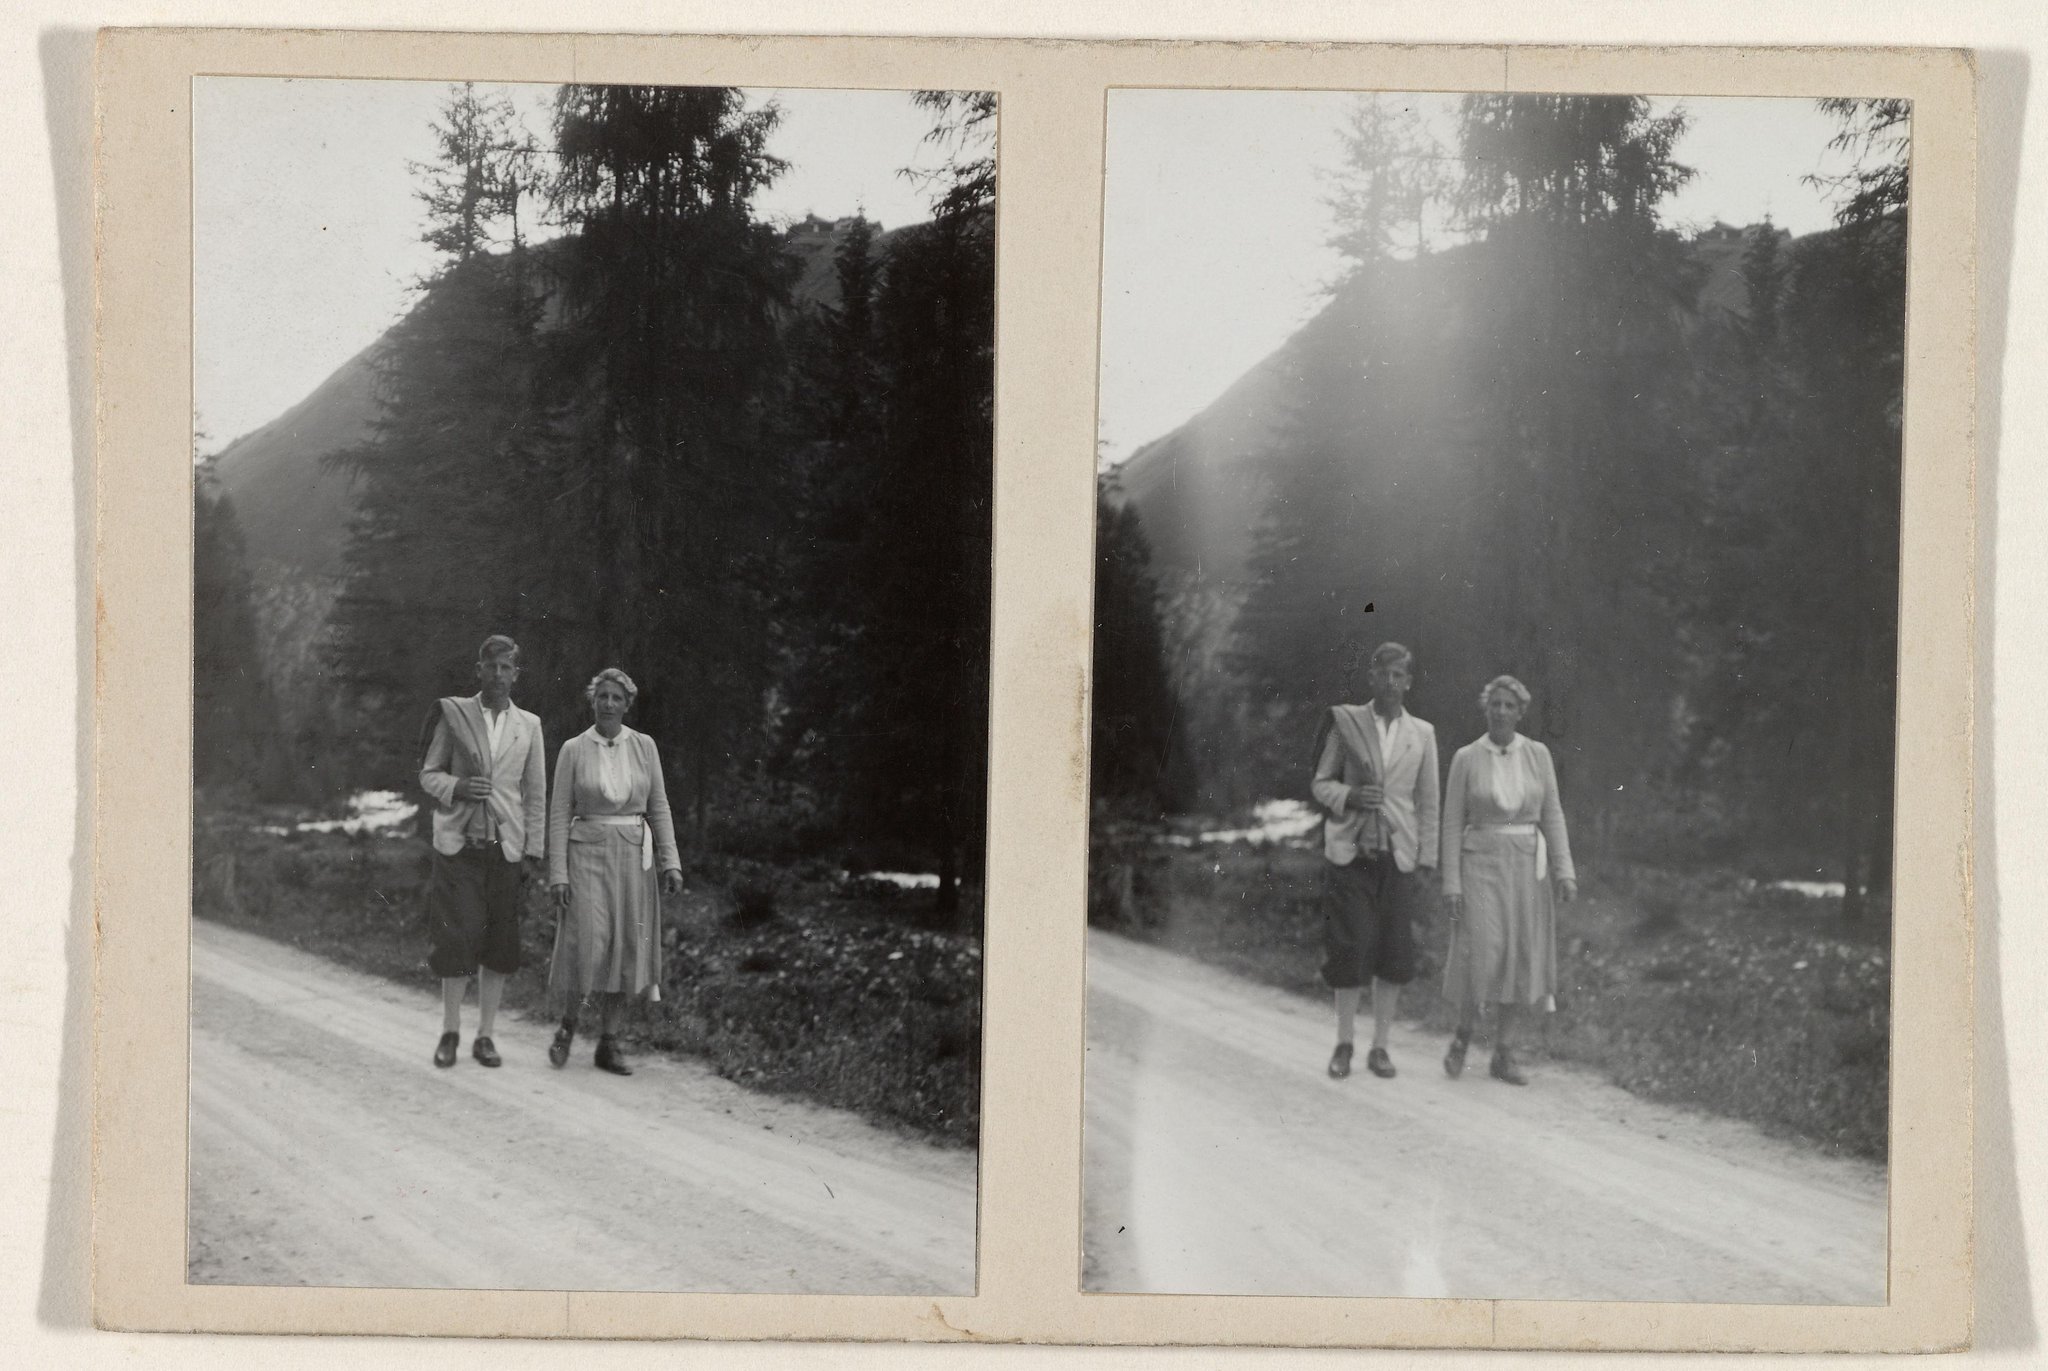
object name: stereograph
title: Op de weg van Bergün naar de Keschhütte.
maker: geldolph adriaan kessler (dolph)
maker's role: fotograaf, industrieel, voetballer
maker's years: 1884-1945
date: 1895-1920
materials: paper, photographic support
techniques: collodion silver print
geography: netherlands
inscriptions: title: ‘Op de weg van Bergün naar de Keschhütte.’